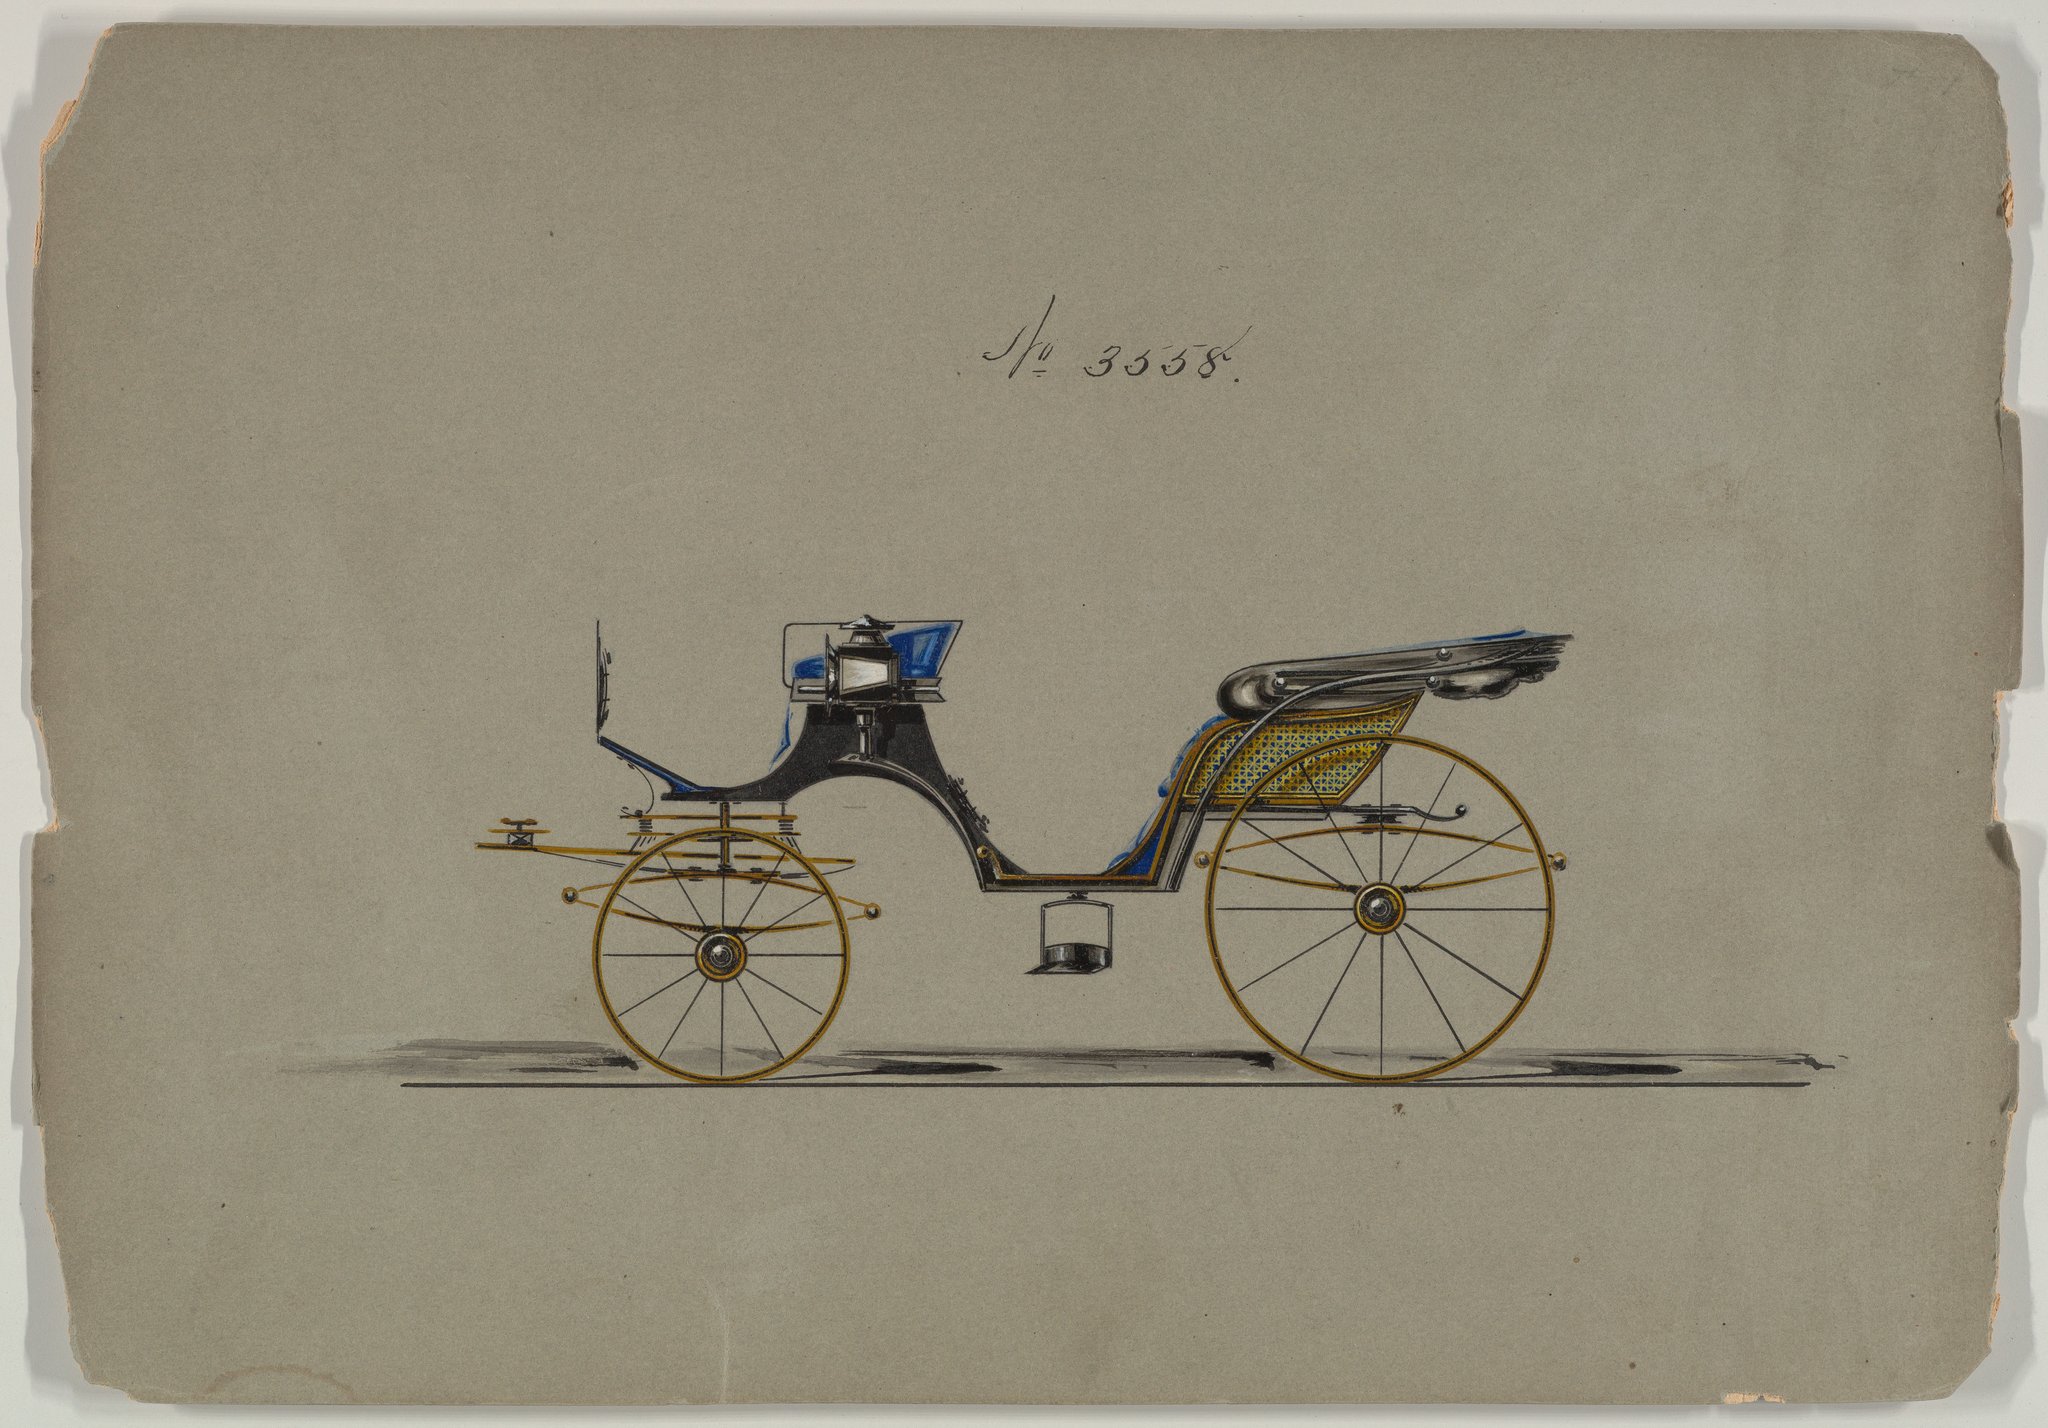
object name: drawing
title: Cabriolet/Victoria #3558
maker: brewster & co.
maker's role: manufacturer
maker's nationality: american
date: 1879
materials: gouache, gum arabic, ink, watercolor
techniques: pen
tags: carriages